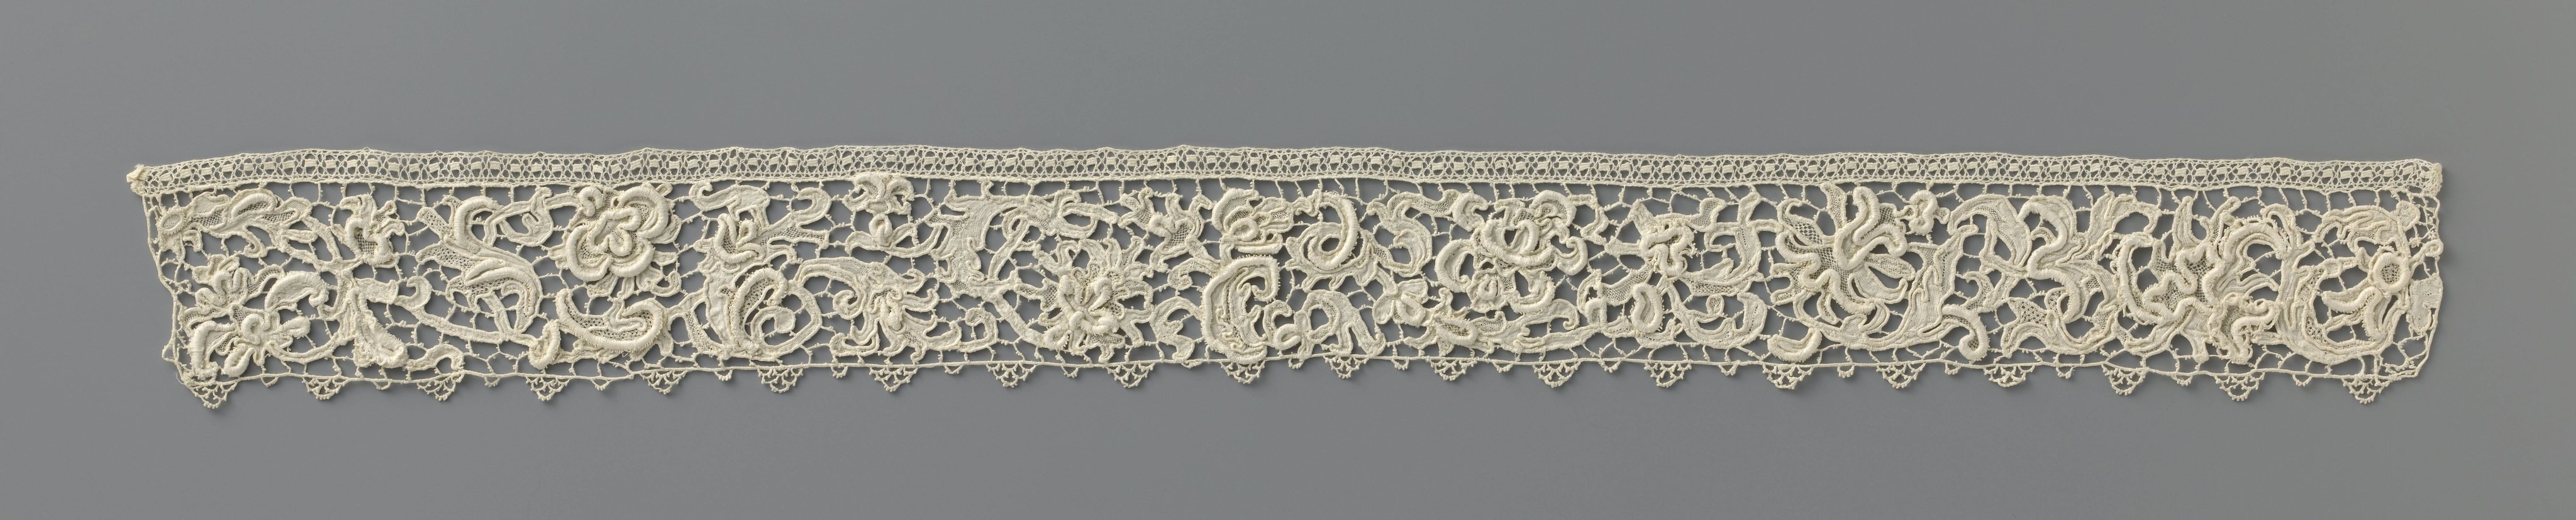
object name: strip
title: Strook naaldkant met spichtige bloemen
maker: Anonymous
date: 1875-1909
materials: linen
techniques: gros point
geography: burano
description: Strook naturelkleurige Venetiaanse naaldkant "gros point". Op een open spijlengrond staat een lopende rank met veelsoortige kleine bloemen, die met spichtige, sterk gekromde bloemblaadjes zijn bezet. Ook de rijk gevarieerde bladvoluten, zijn sterk gekromd.